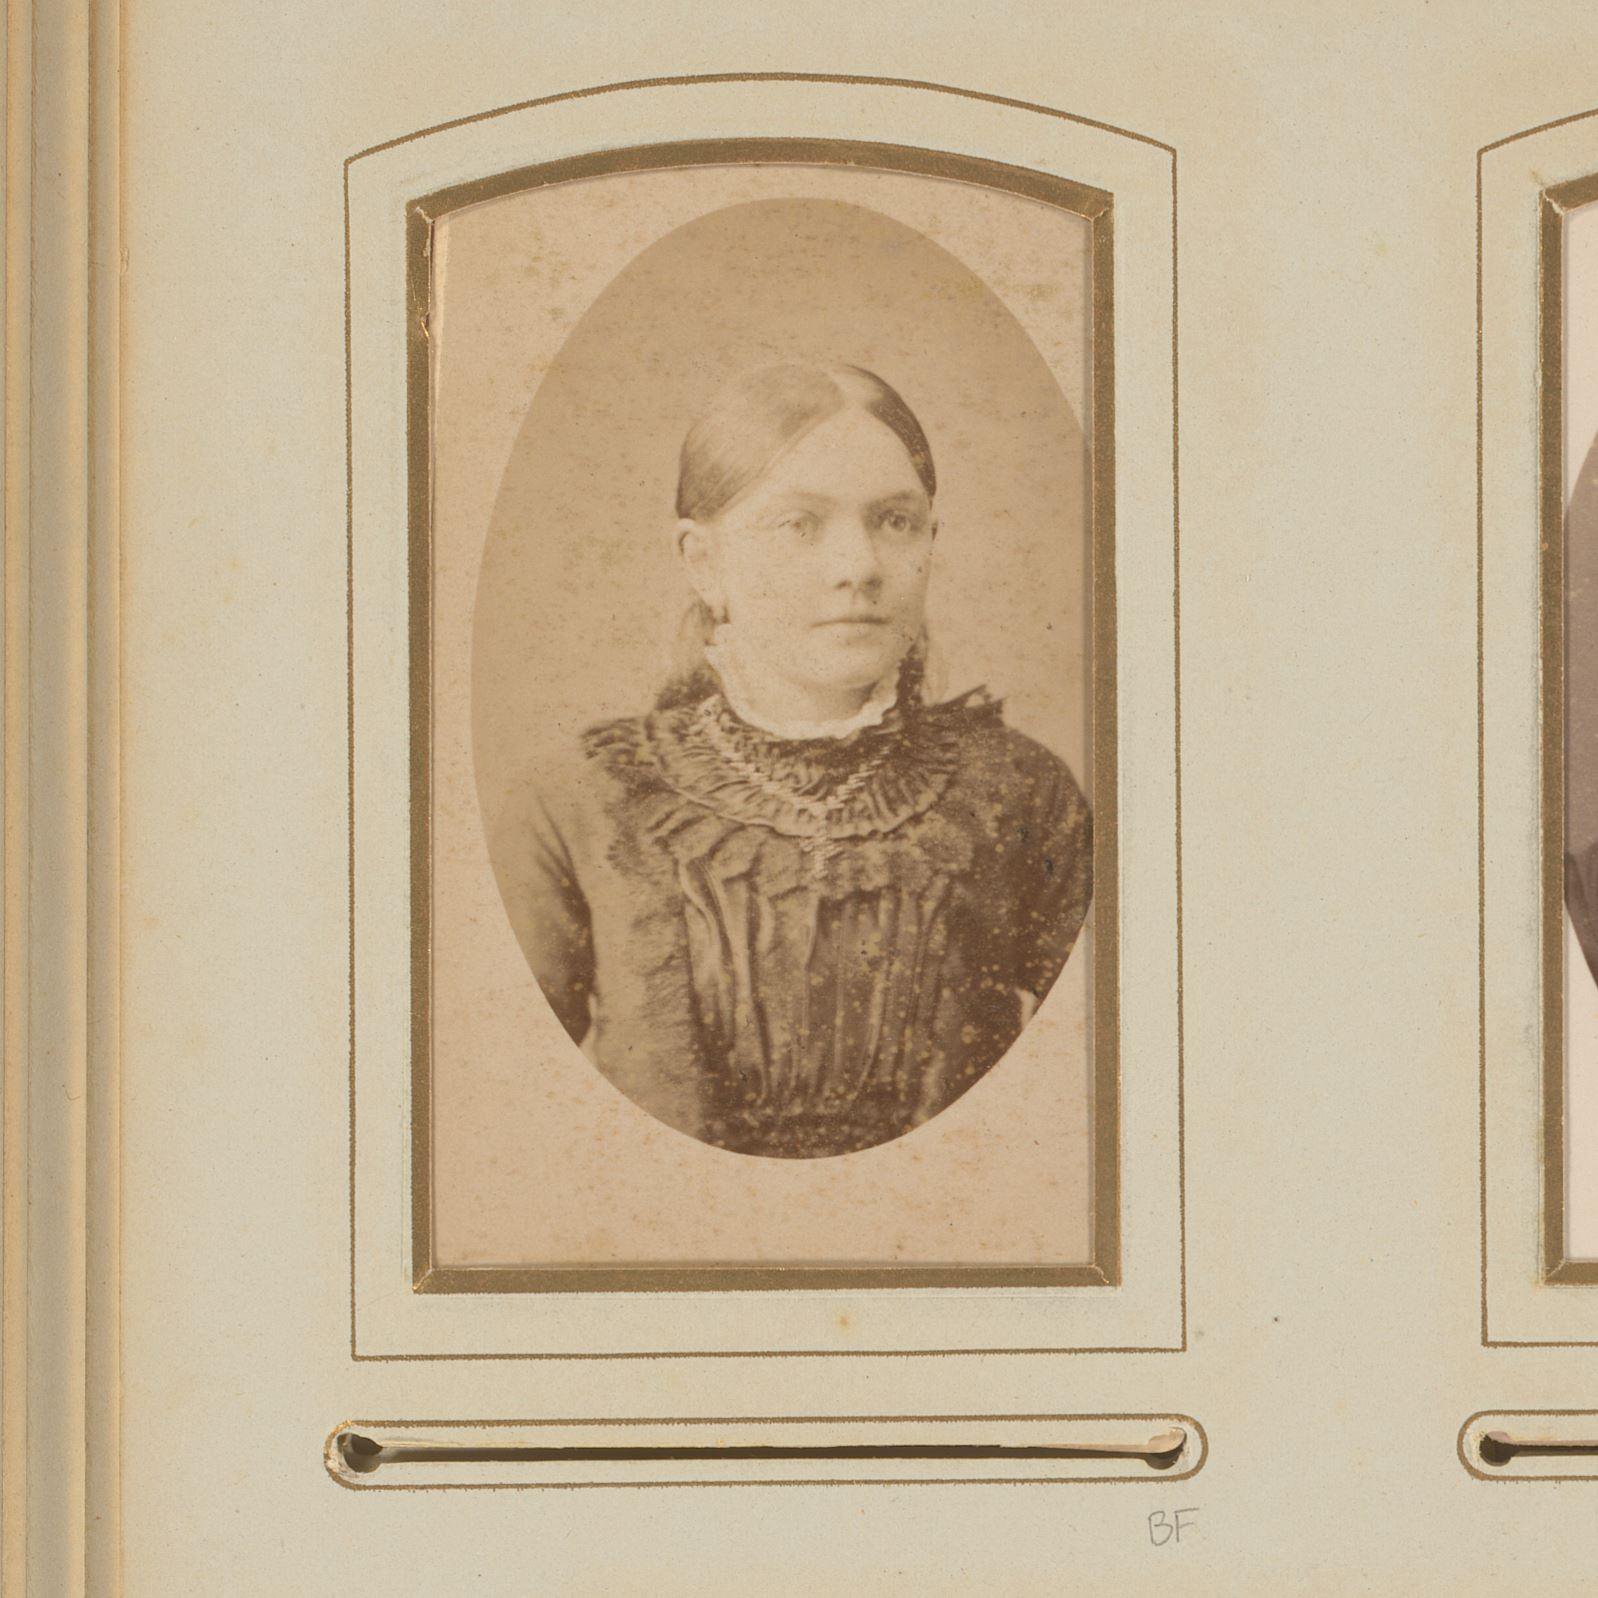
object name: album leaf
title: Portret van een meisje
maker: bertha steinfels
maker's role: fotograaf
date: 1860-1900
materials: cardboard, photographic support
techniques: albumen print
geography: aachen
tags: historical persons - bb - woman, girl (child between toddler and youth)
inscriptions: inscription: ‘Reproductionen/ Vergrösserungen/ alles Art./ Photogr. Atelier/ von/ Bertha Steinfels/ AACHEN/ Wilhelmstrasse 66./ Die Originalplatte bleibt zur Nachbestellung aufbewahrt.’